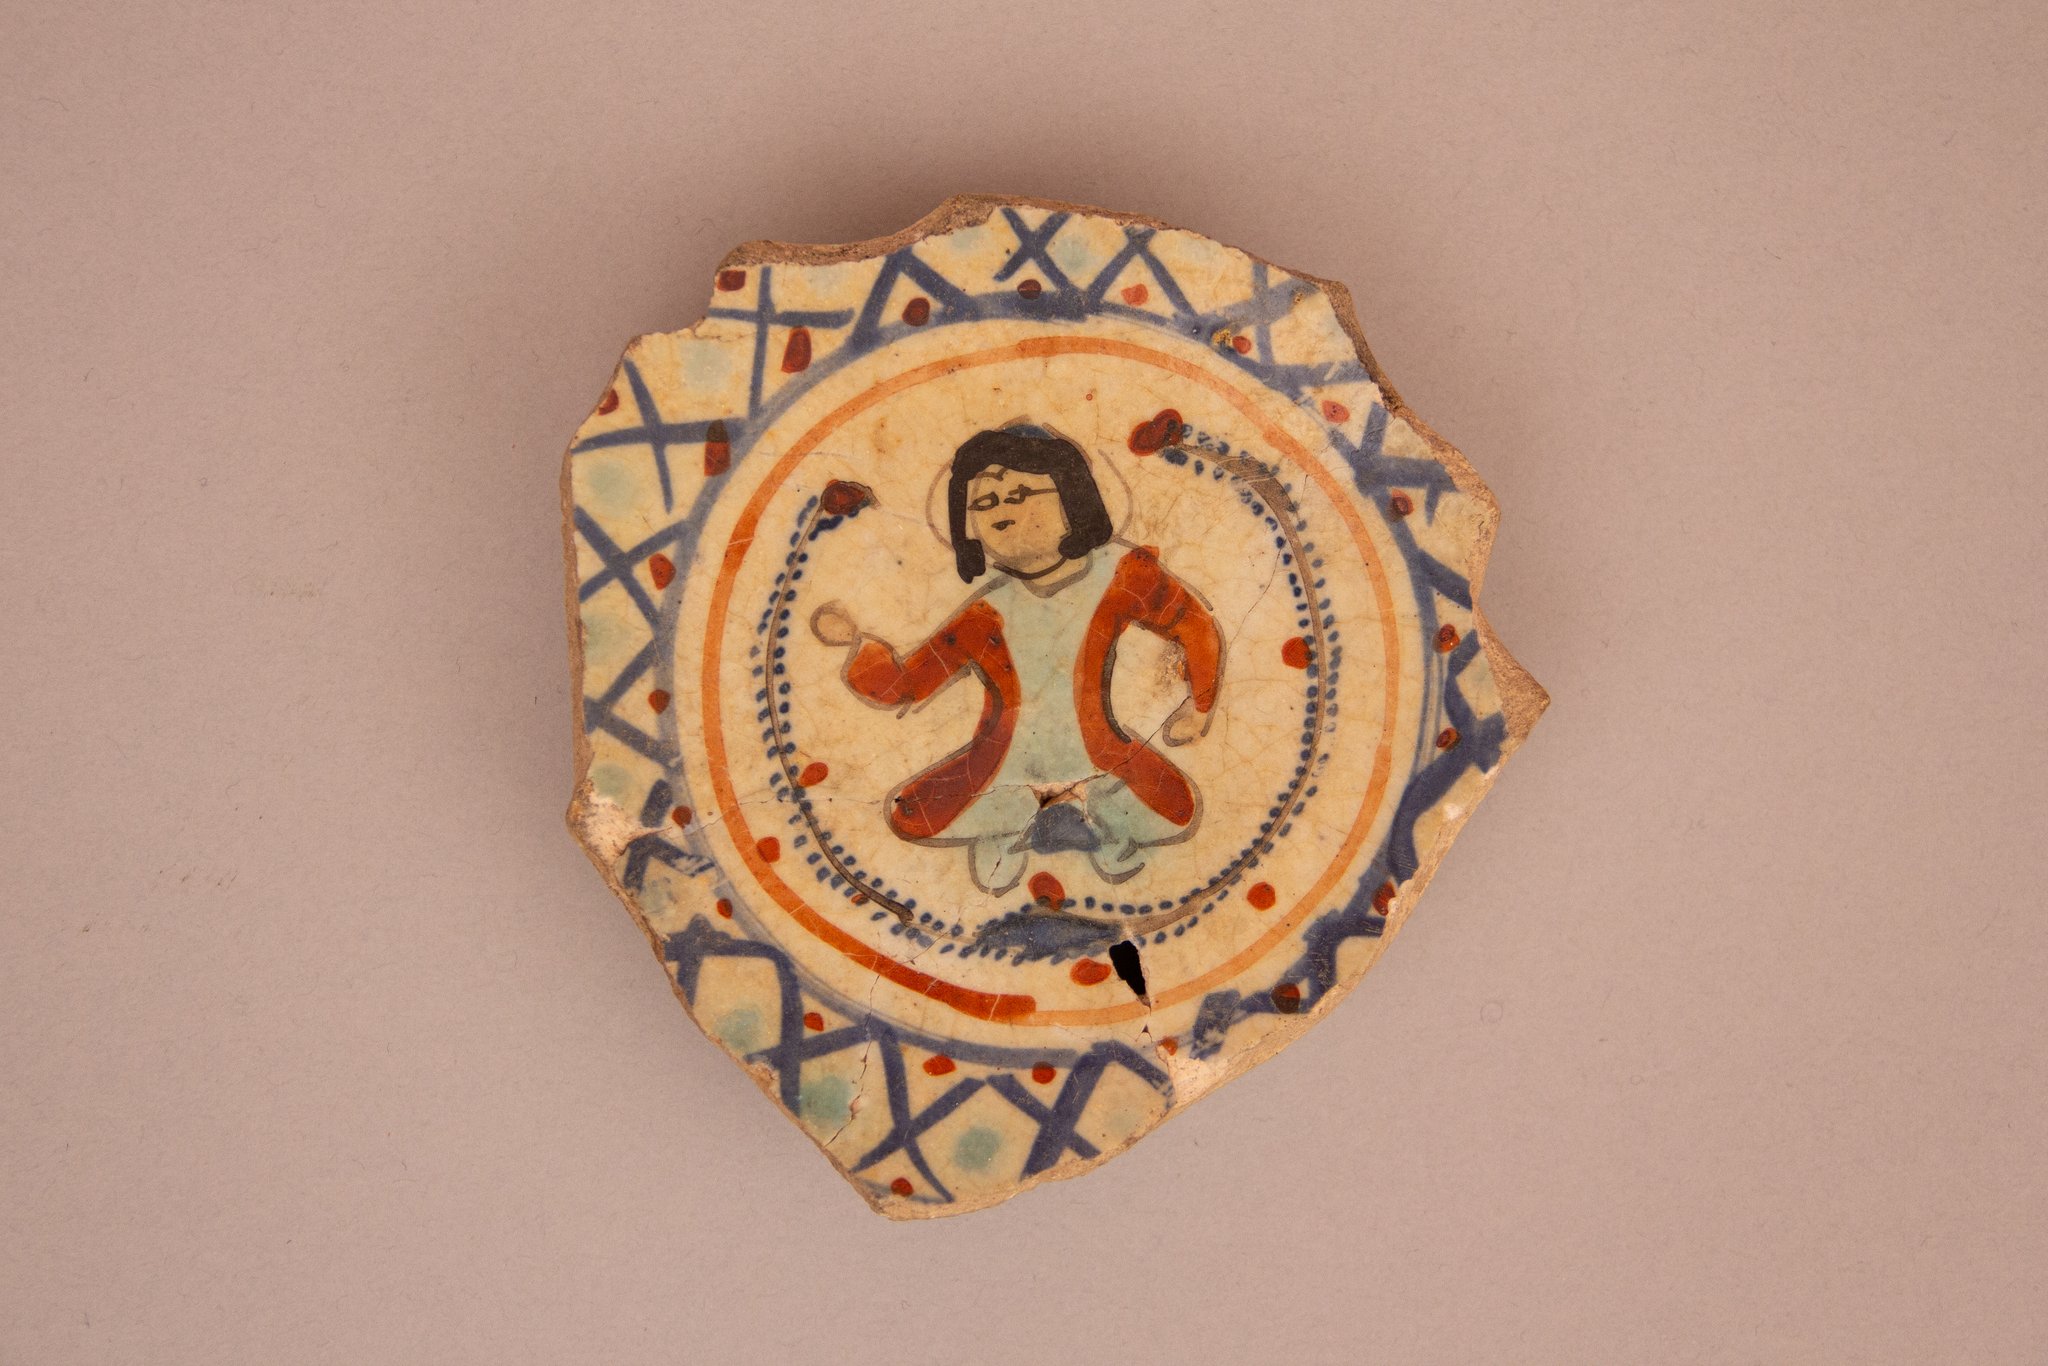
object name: fragment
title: Fragment of a Mina'i Bowl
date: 1101-1300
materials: stonepaste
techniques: overglaze, painting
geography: iran